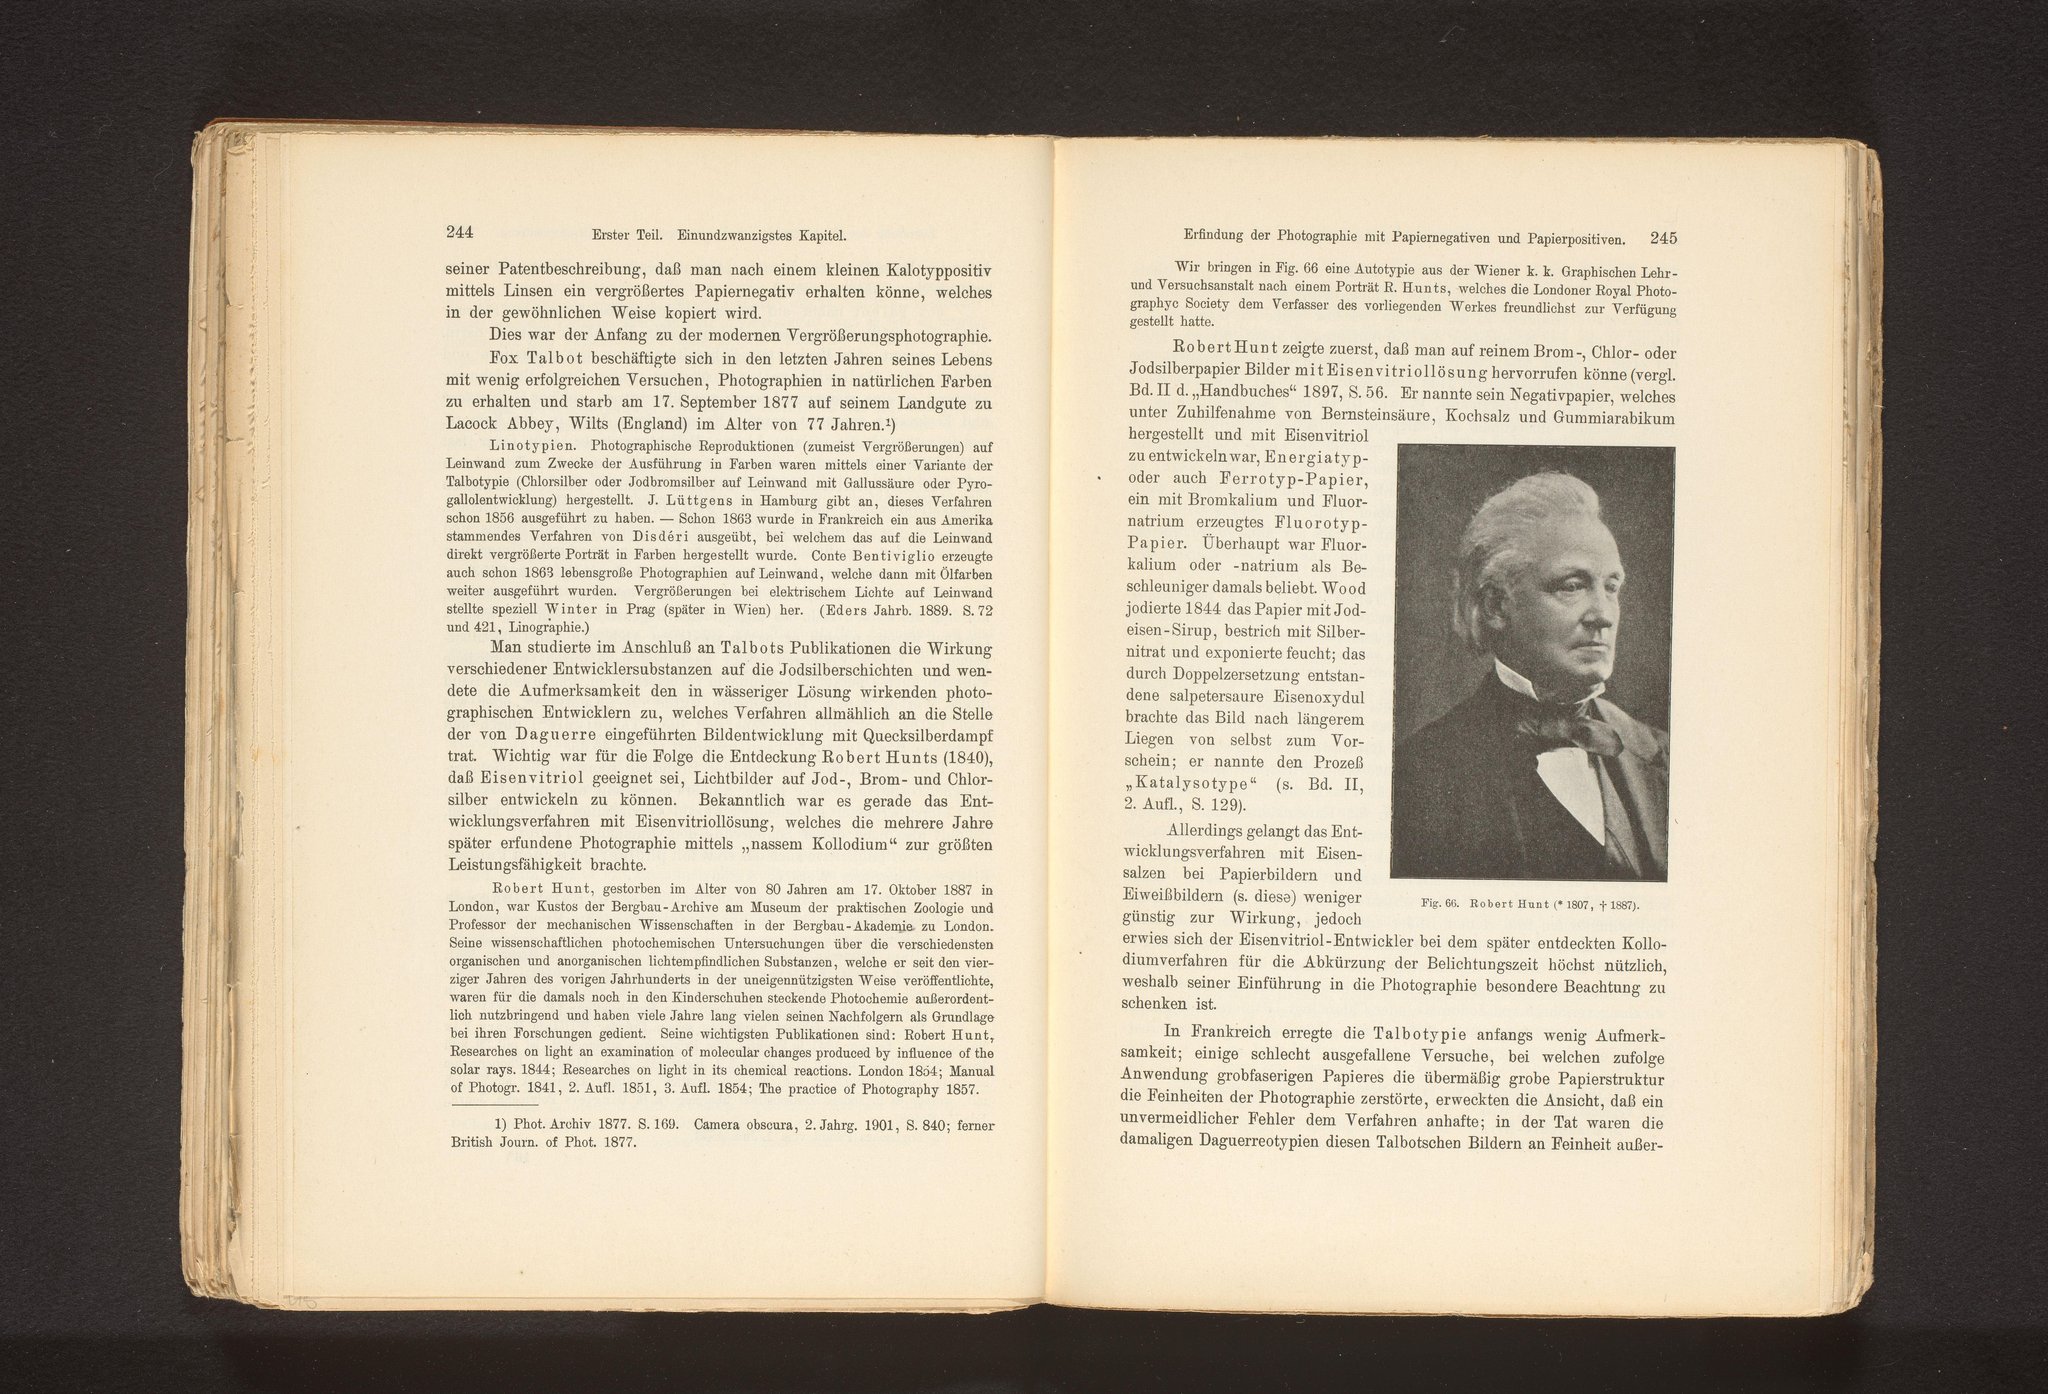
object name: page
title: Robert Hunt (*1807,+1867)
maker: Anonymous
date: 1900-1905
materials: paper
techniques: autotype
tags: adult man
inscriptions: number: ‘Fig. 66.’